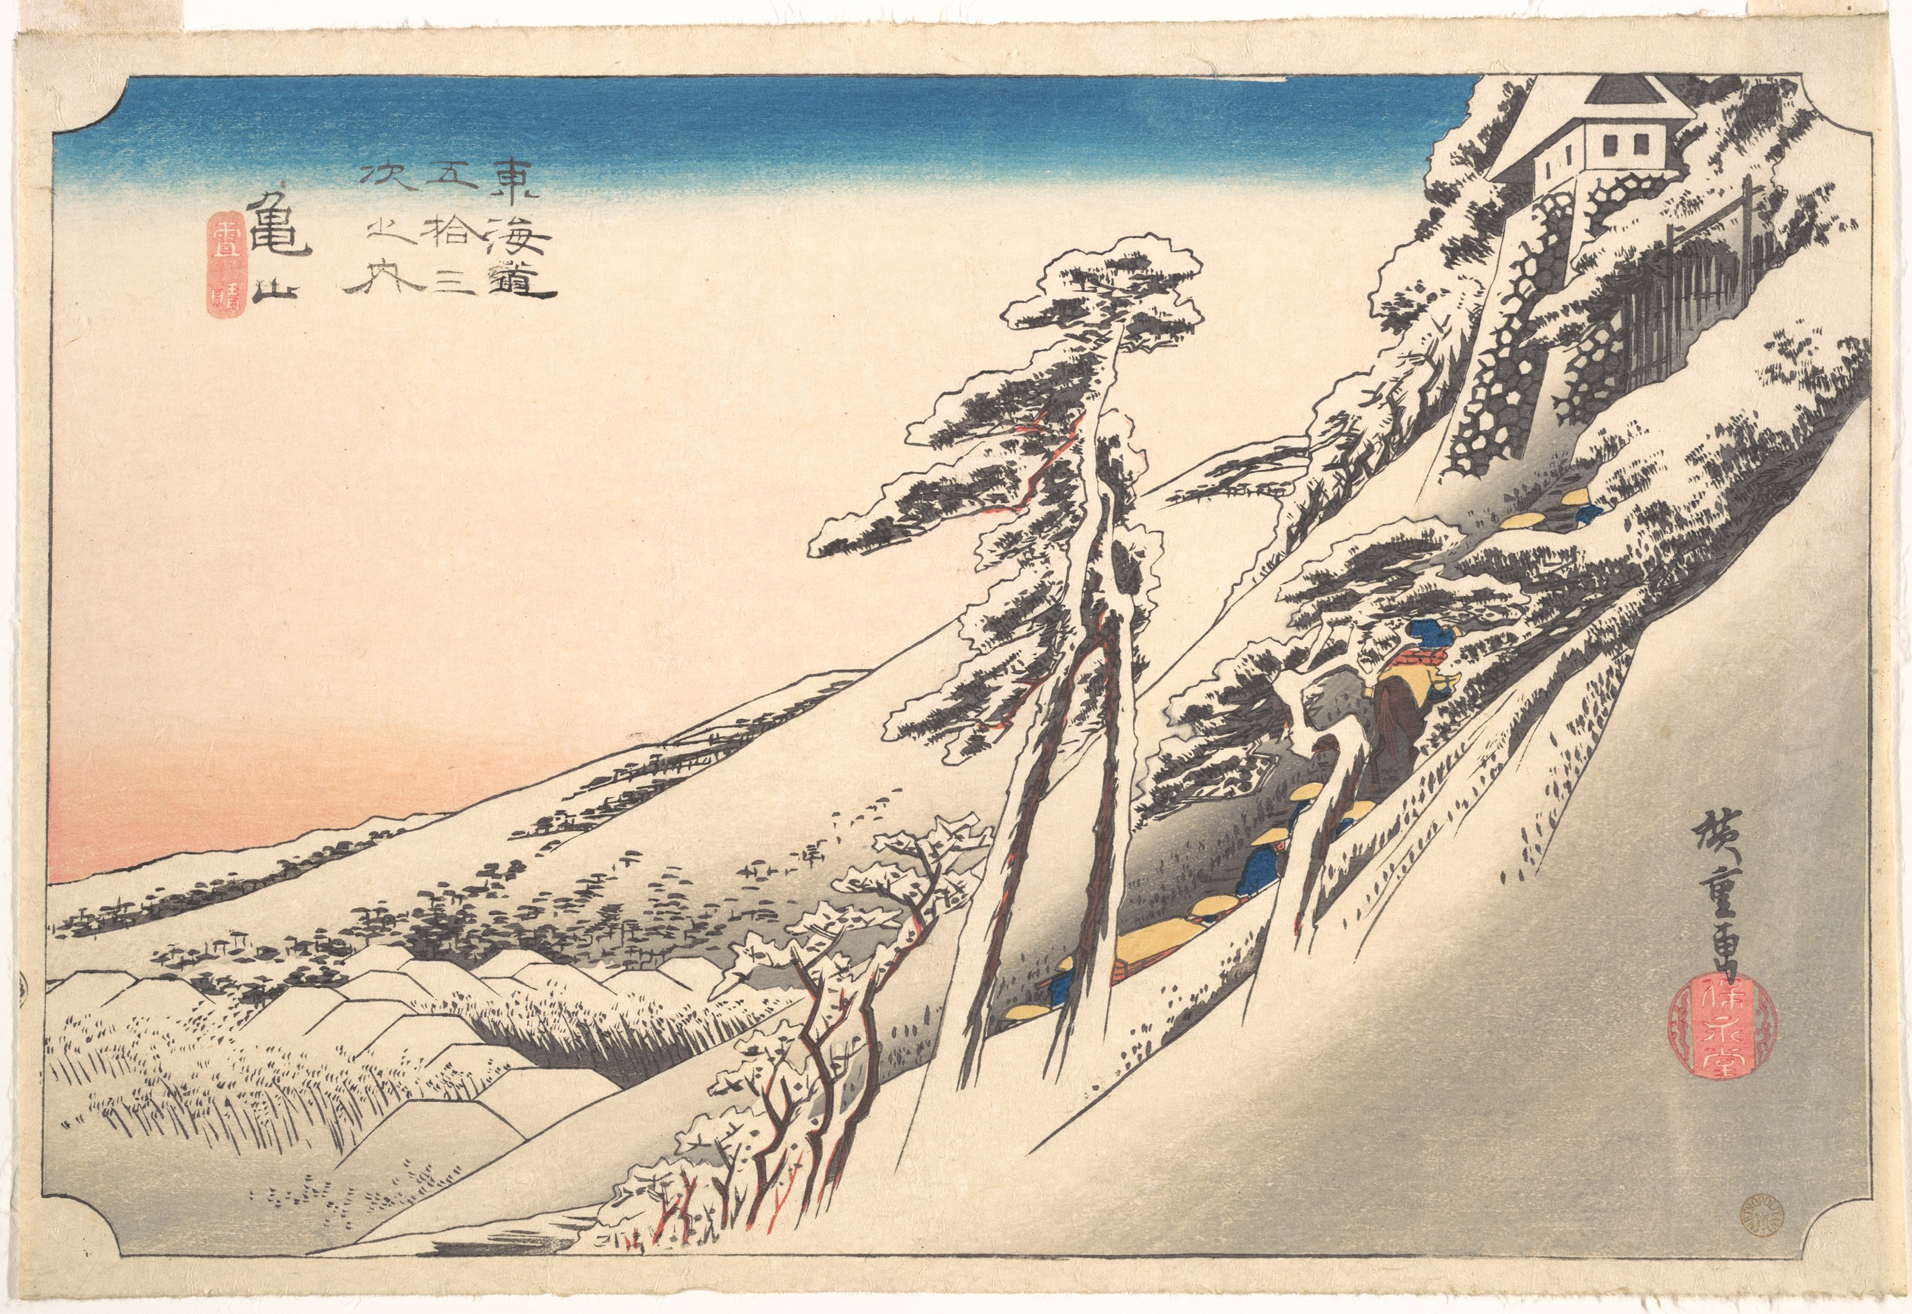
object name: print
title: Kameyama, Yuki Hare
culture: japanese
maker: utagawa hiroshige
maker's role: artist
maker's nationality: japanese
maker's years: 1797-1858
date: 1834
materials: ink, paper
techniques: woodblock print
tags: trees,winter,snow